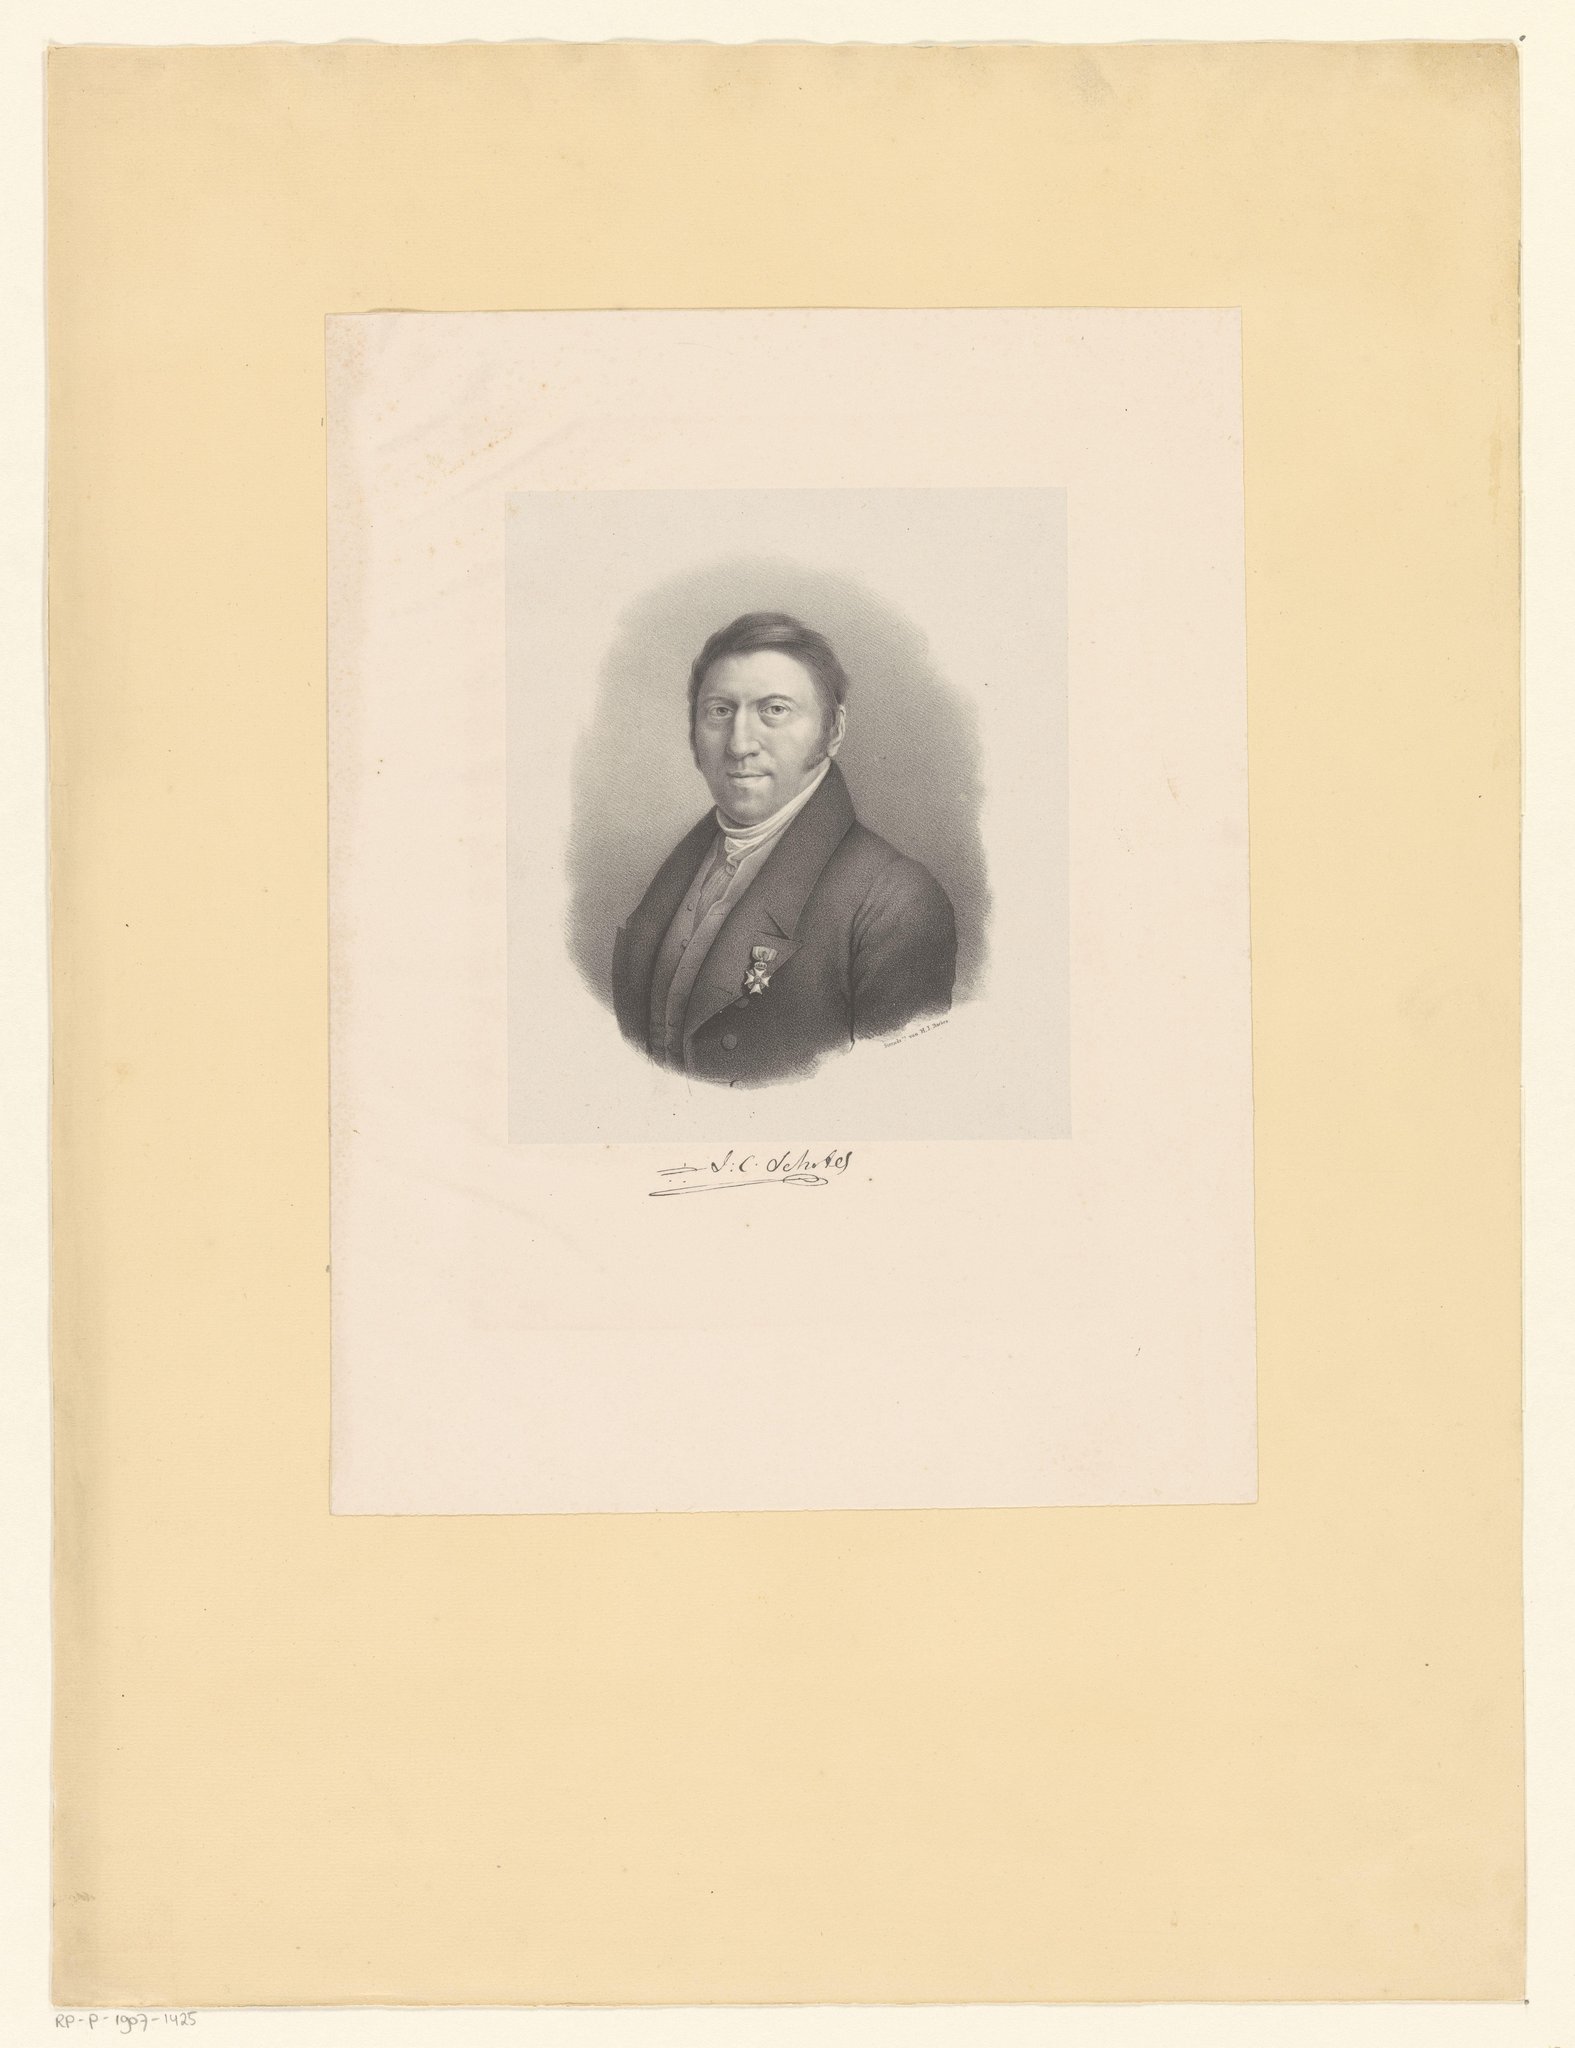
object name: print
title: Portret van kunstenaar Johannes Christiaan Schotel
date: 1822-1845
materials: paper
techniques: lithograph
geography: dordrecht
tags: dordrecht, painter, print maker, draughtsman, johannes christiaan schotel, knighthood order, historical persons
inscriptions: collector's mark: Lugt 2228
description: De geportretteerde draagt een ridderorde op de borst. Onder het portret zijn signatuur.